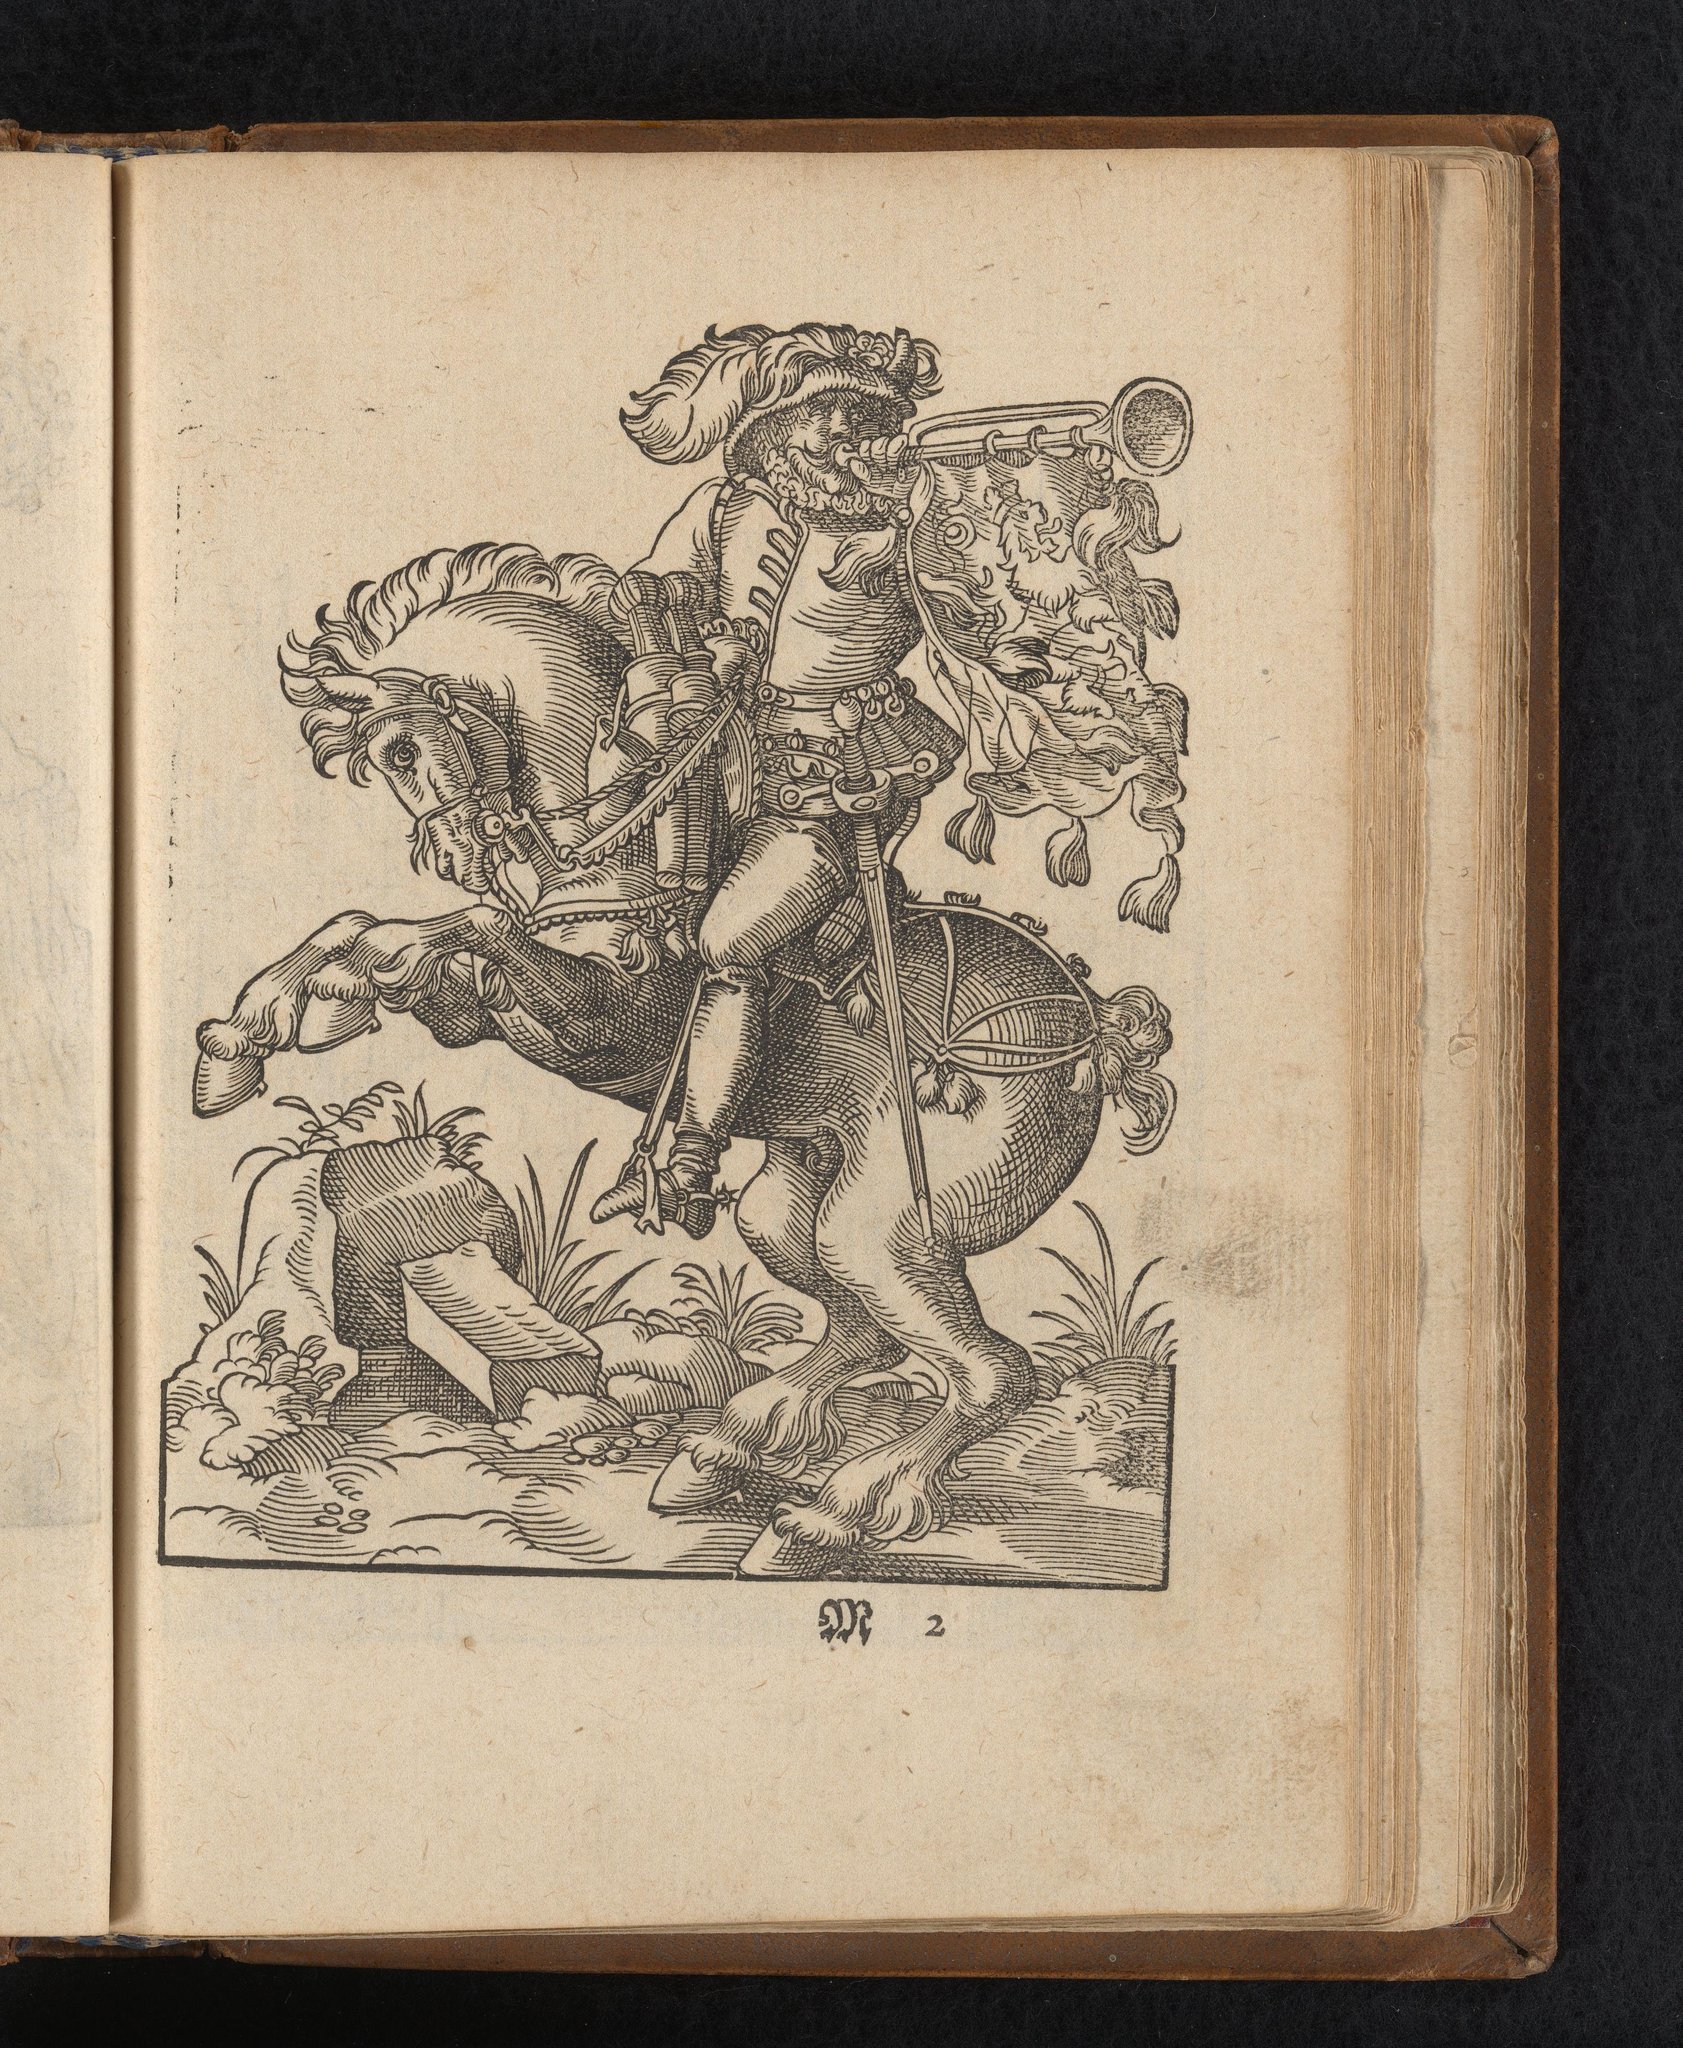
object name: print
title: Trompetter te paard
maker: Anonymous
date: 1578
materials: paper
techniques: woodcut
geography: nuremberg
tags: riding a horse, ass, or mule; rider, horseman, rearing (horse in motion), horn, trumpet, cornet, trombone, tuba, (military) signals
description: Trompetter op een steigerend paard. Onderdeel van het modelboek Enchiridion artis pingendi, fingendi & sculpendi met 108 figuren bedoeld voor beginnende schilders, beeldhouwers en prentmakers.